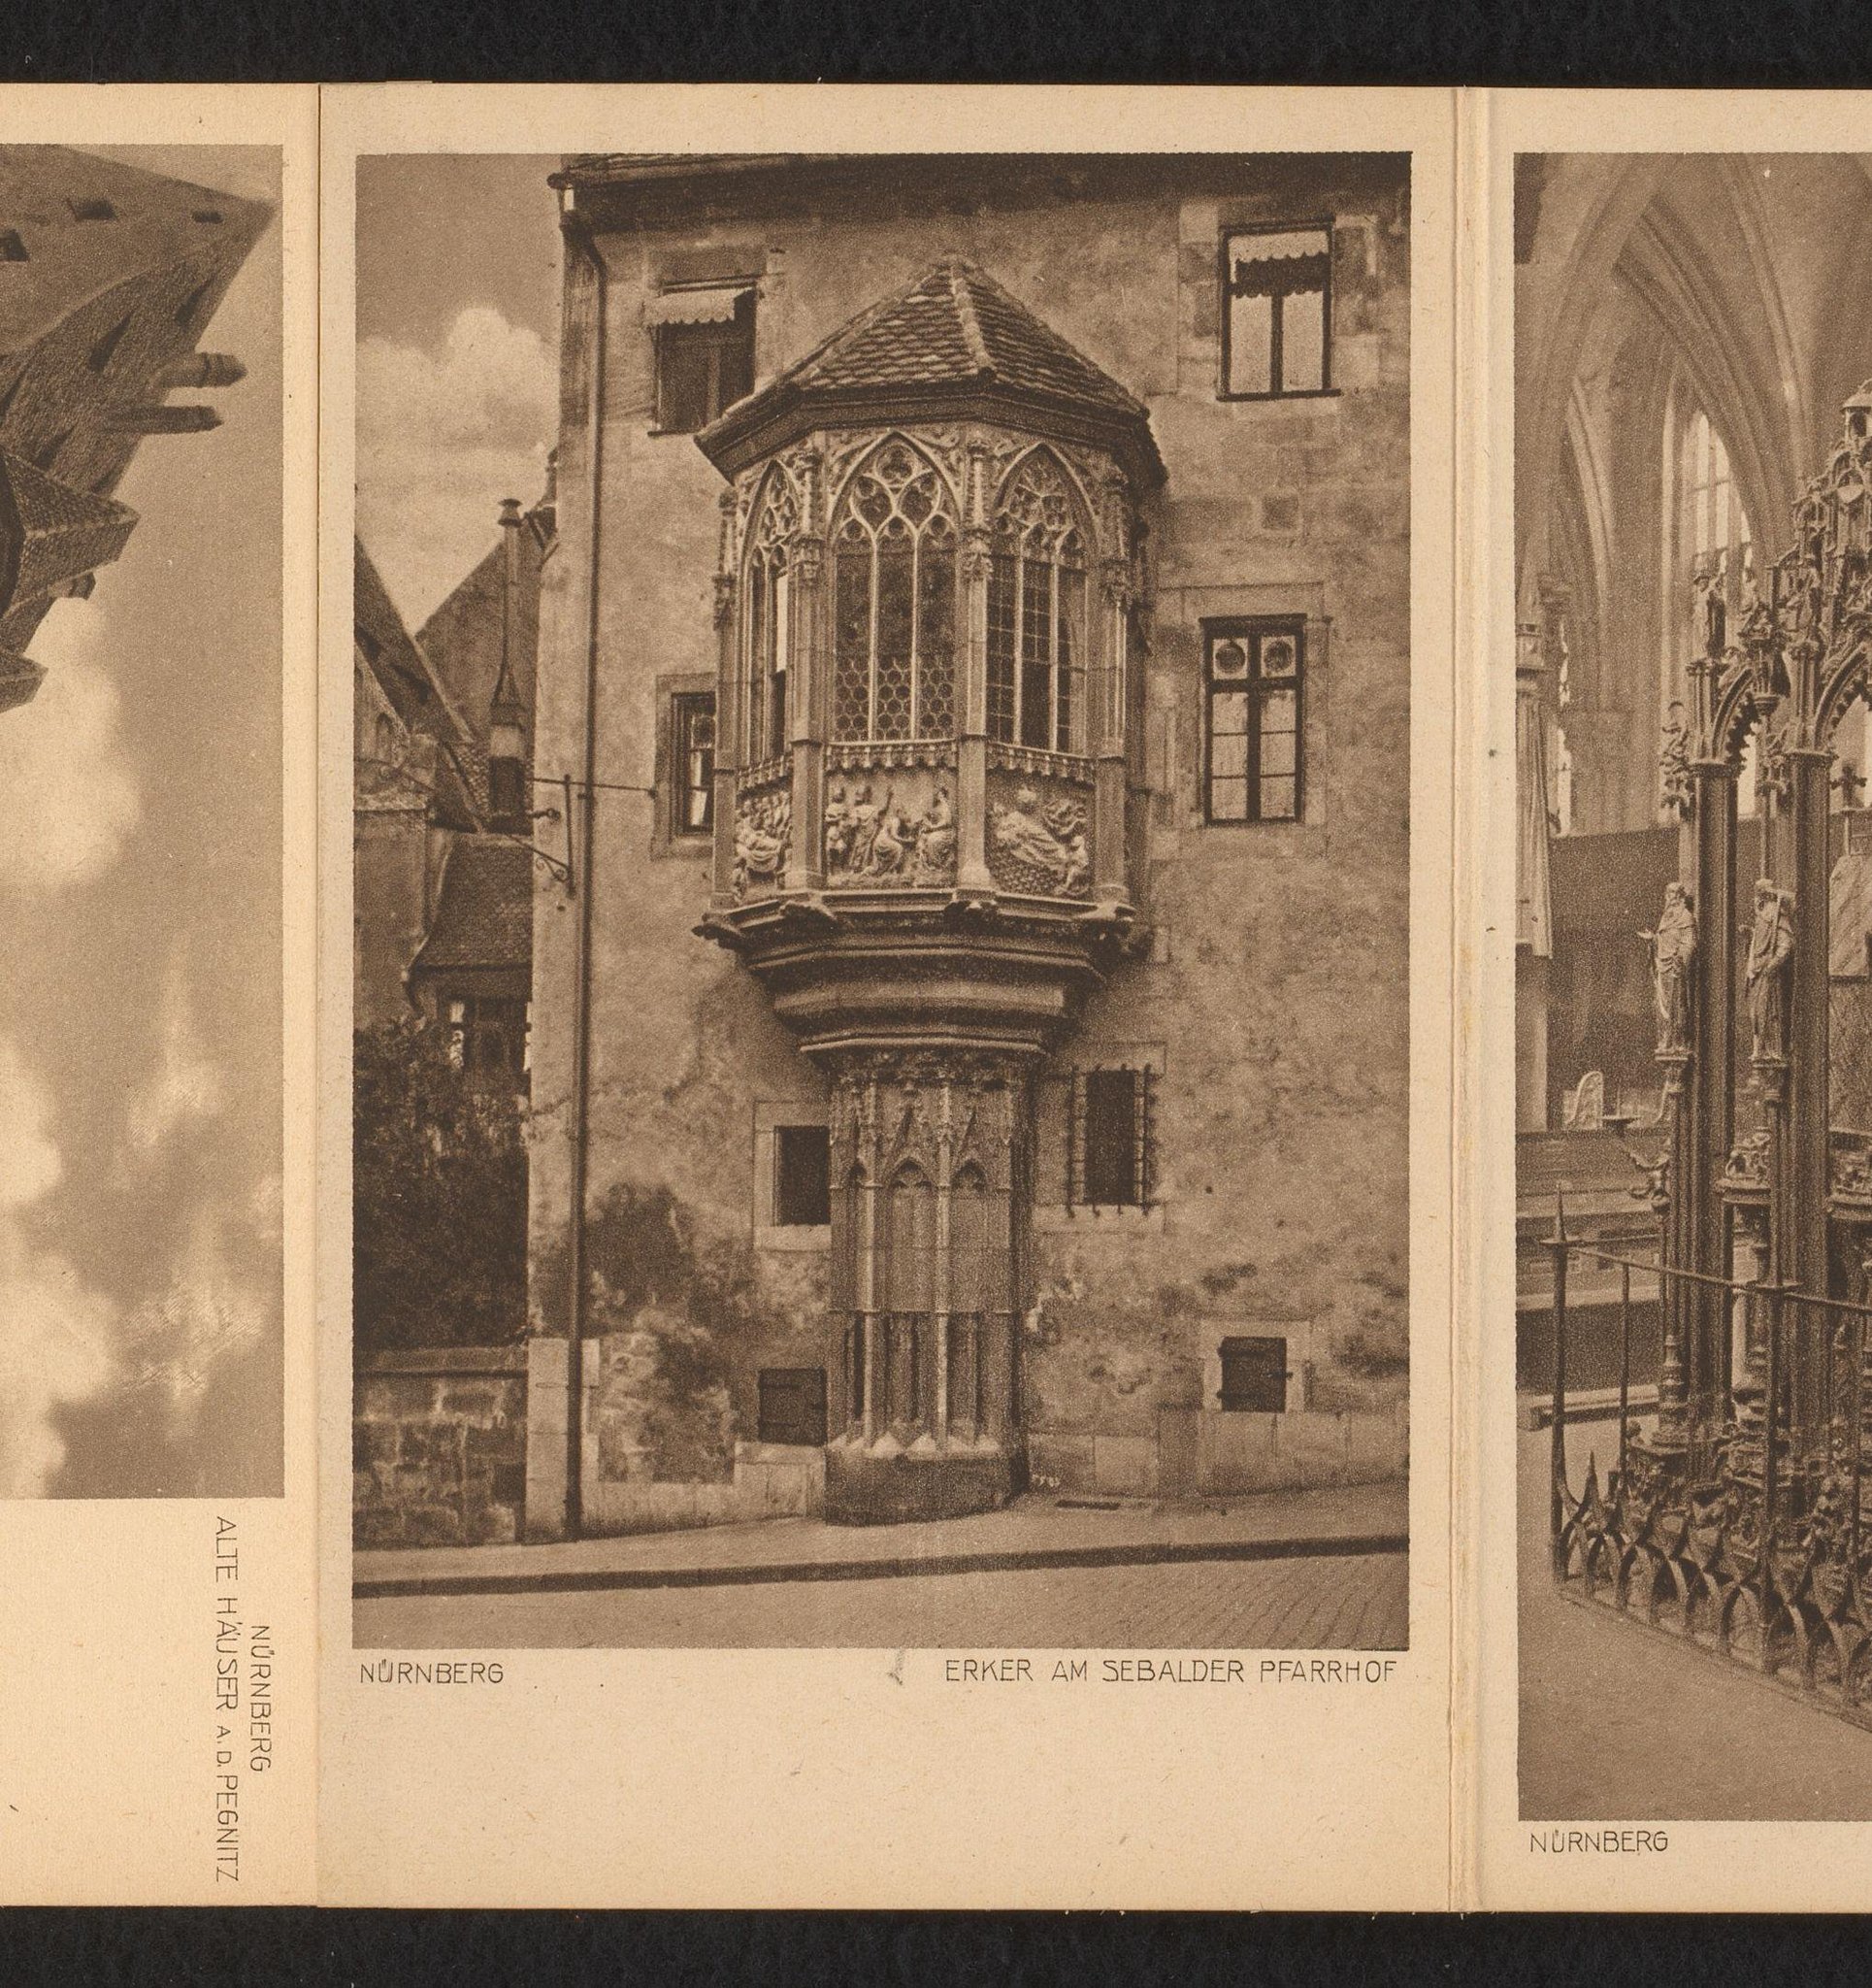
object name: ansichtkaart, prentbriefkaart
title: Nürnberg. Sebaldusgrab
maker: Anonymous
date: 1905-1930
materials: cardboard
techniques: rotogravure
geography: nuremberg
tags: grave, tomb, interior of church